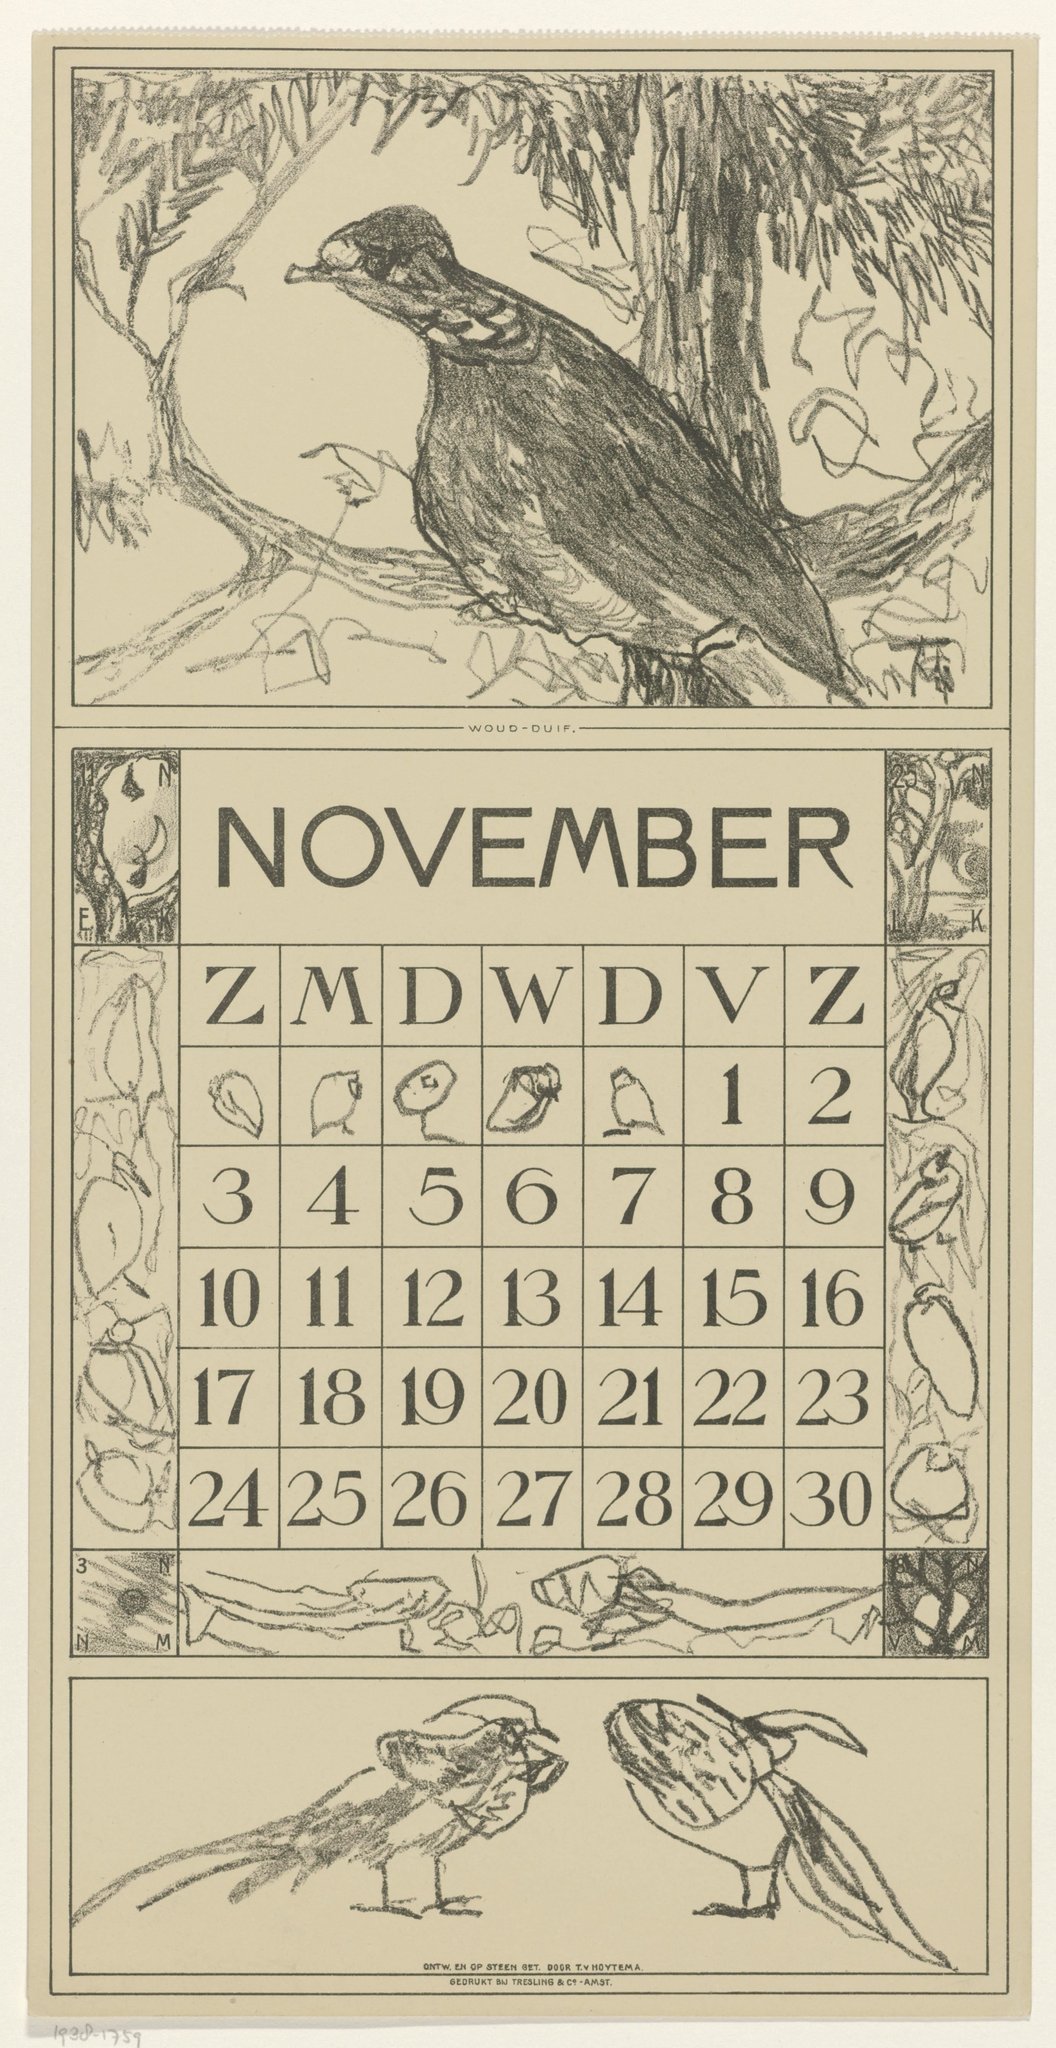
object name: calendar leaf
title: Woud-duif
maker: theo van hoytema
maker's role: draughtsman, painter, print maker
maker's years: 1863-1917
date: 1917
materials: paper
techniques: lithograph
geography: voorburg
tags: lunar year, november ~ other concepts, doves, pigeons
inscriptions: collector's mark: Lugt 2228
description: De duif zit op een tak in een boom. Onderin nog twee vogels. In de hoeken de standen van de maan op vier dagen. Bovenaan het blad een scheurlijn.